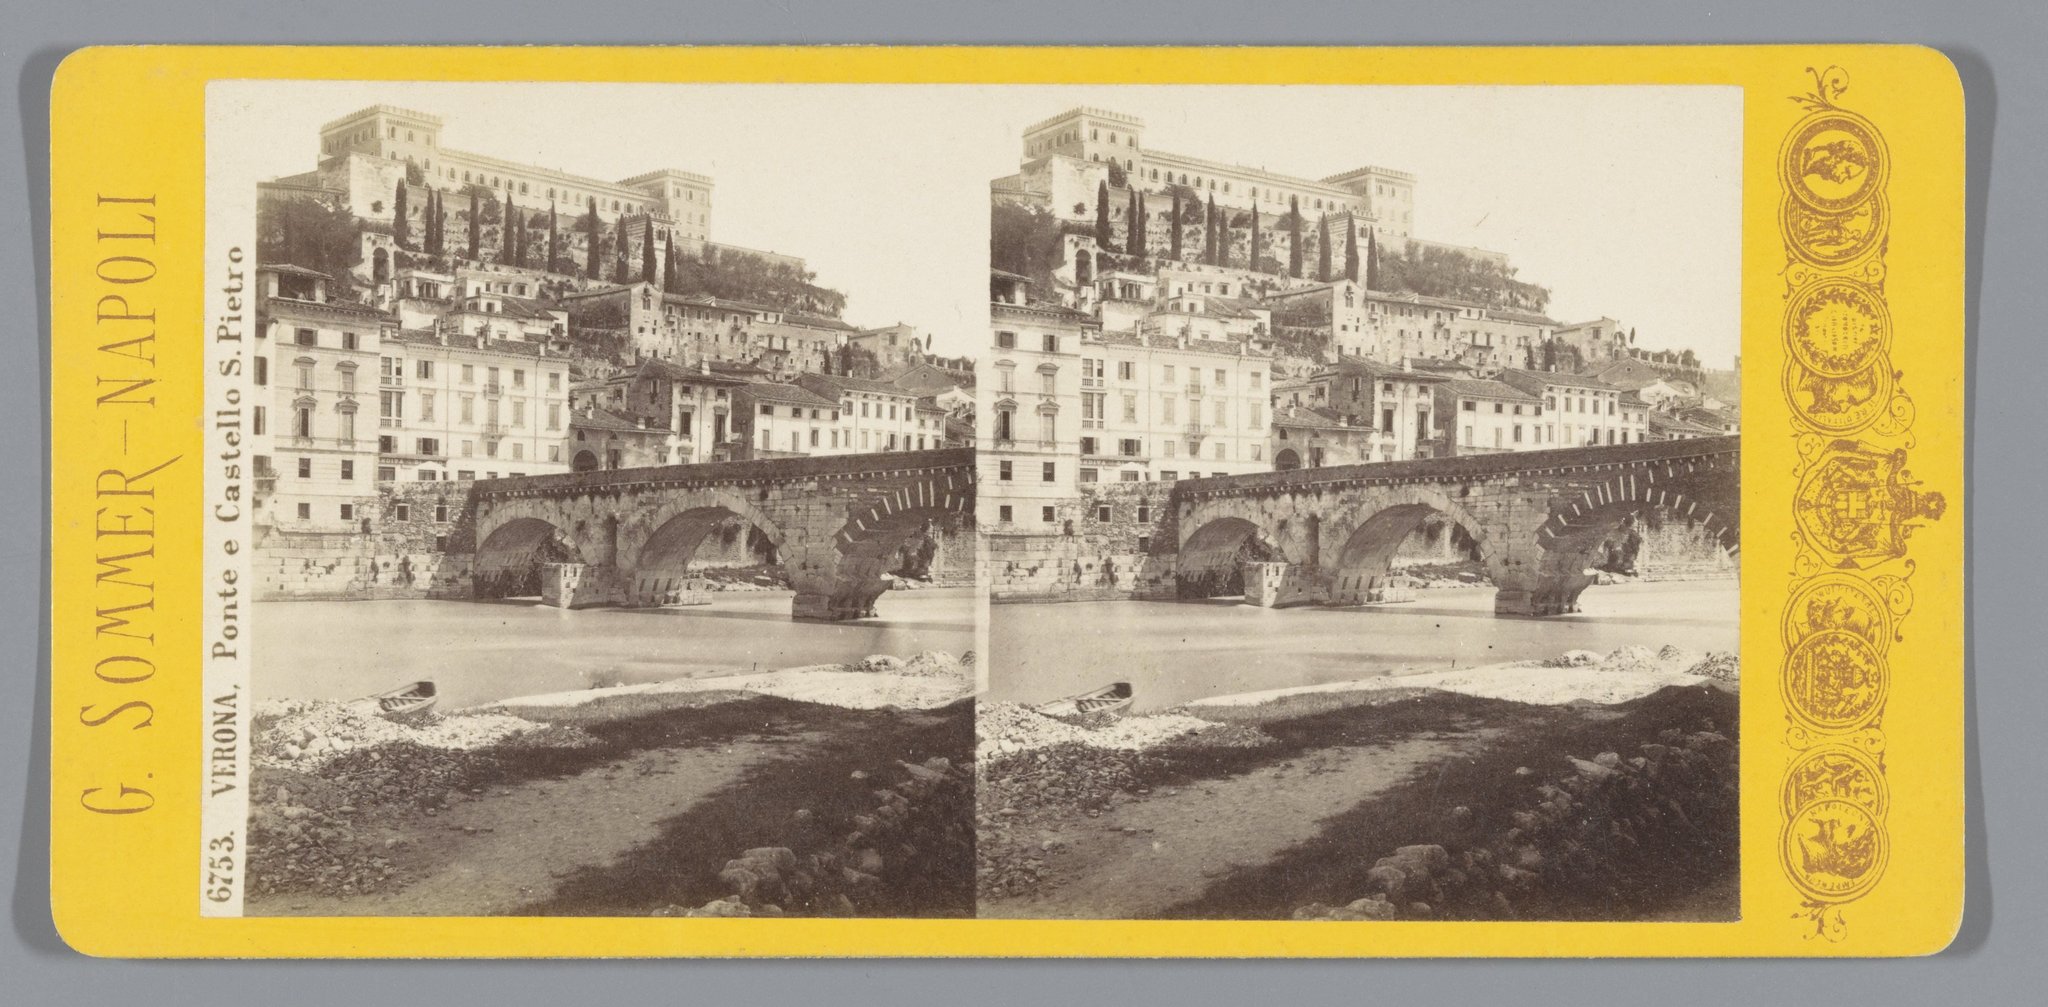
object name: stereograph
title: VERONA, Ponte e Castello S. Pietro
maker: giorgio sommer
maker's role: fotograaf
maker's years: 1834-1914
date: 1860-1880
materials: cardboard, photographic support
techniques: albumen print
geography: verona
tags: city-view, and landscape with man-made constructions, bridge in city across river, canal, etc.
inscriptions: number: ‘6753.’